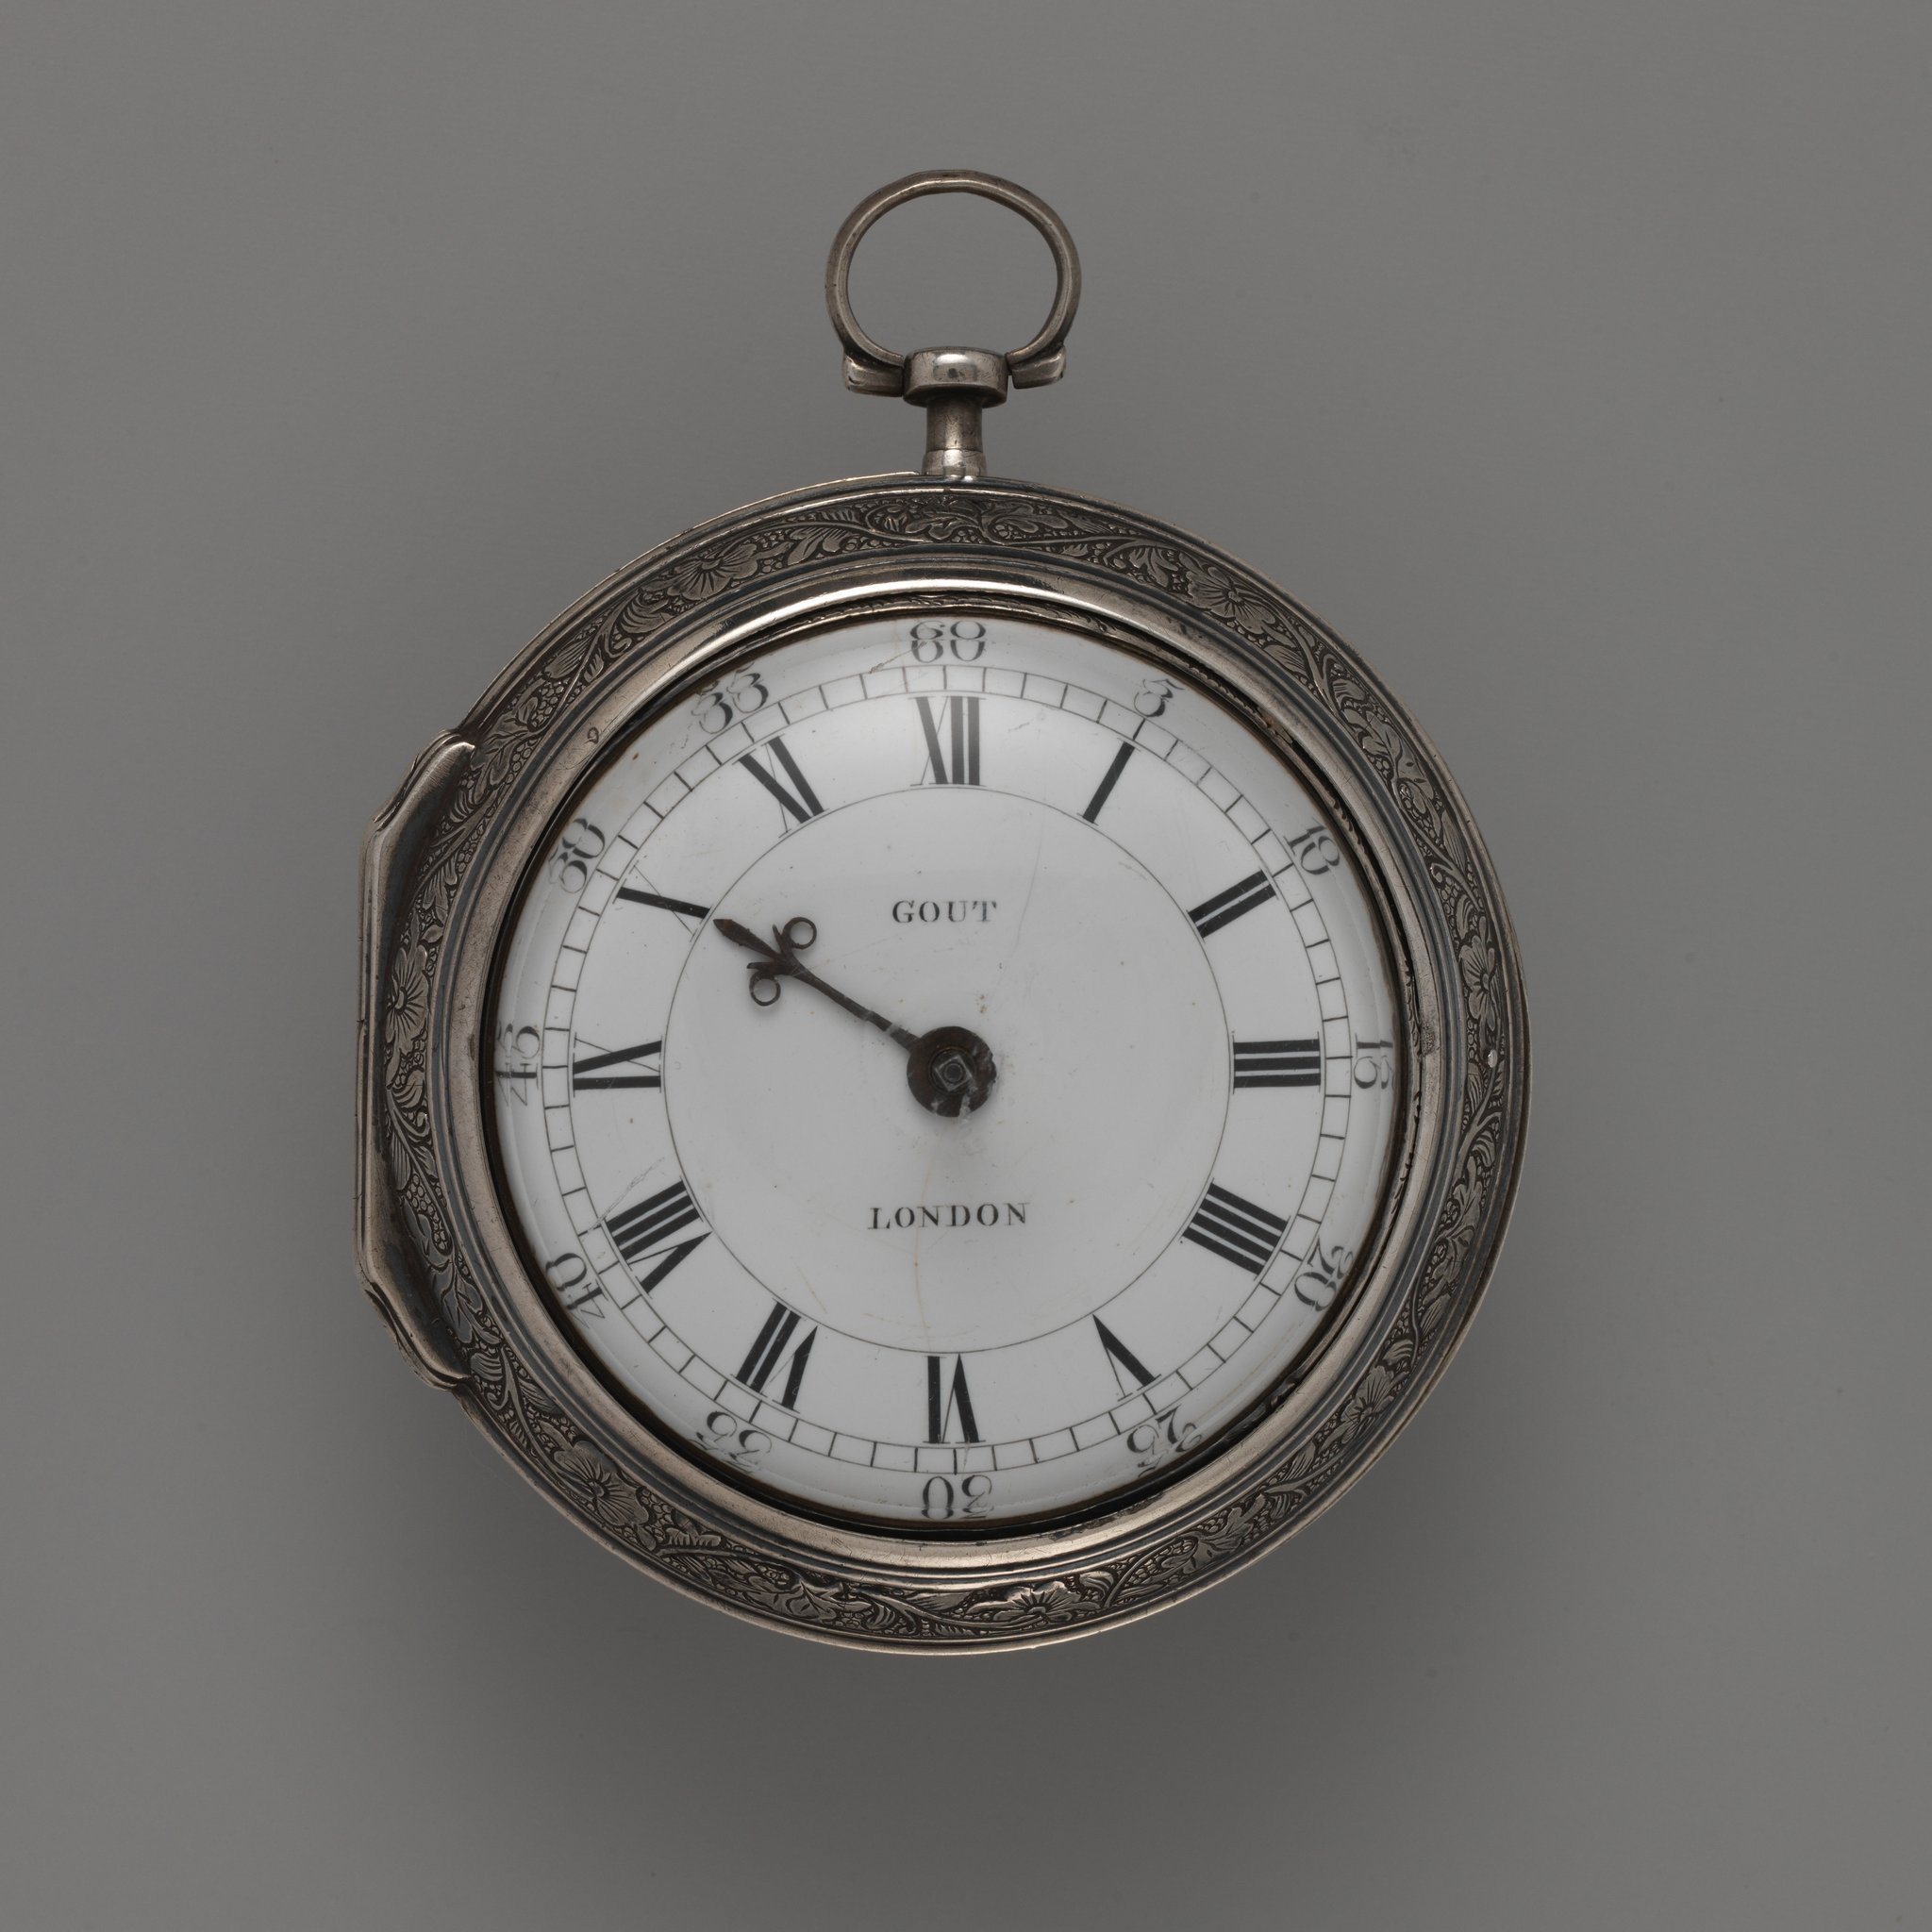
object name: watch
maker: ralph gout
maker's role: maker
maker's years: 1770-1796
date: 1801-1900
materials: silver